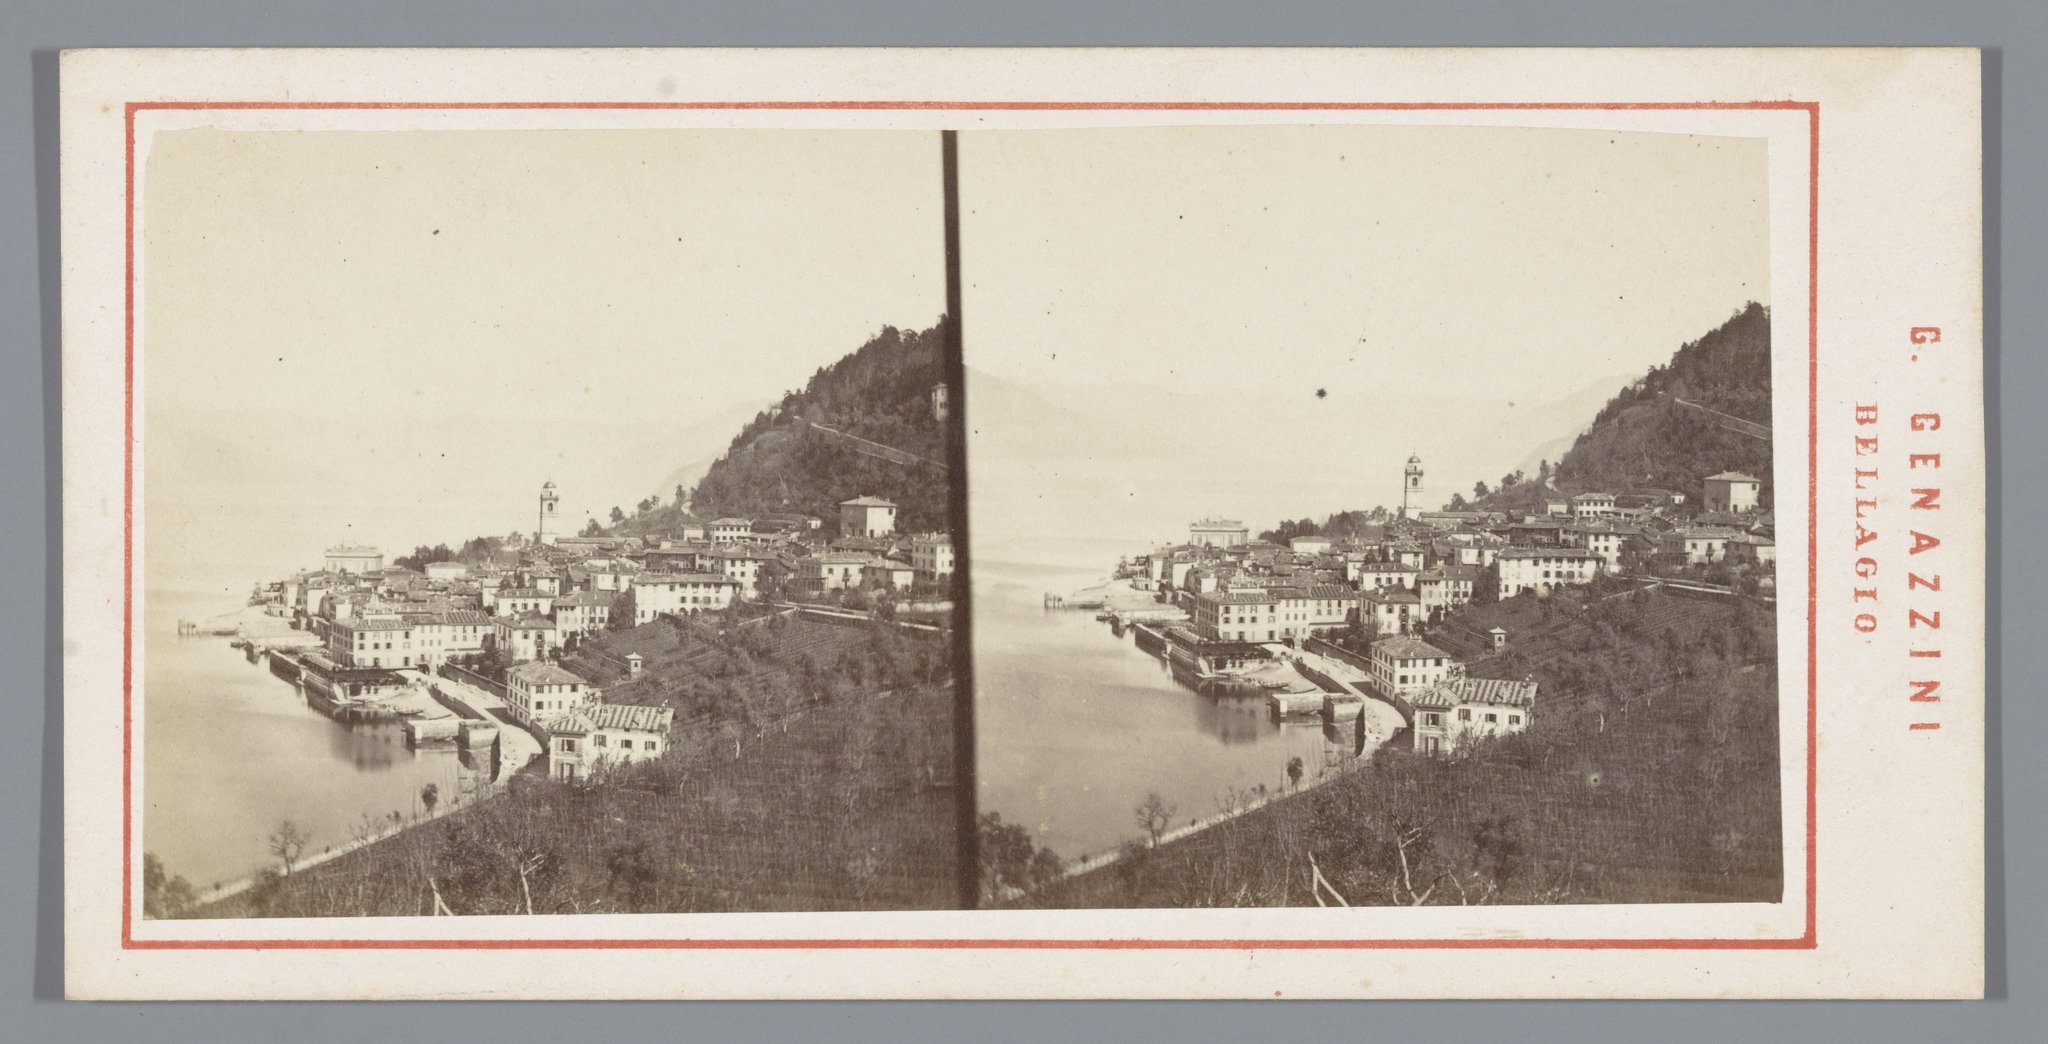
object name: stereograph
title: Gezicht op Bellagio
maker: giorgio genazzini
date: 1860-1870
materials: cardboard, paper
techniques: albumen print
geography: bellagio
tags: prospect of village, silhouette of village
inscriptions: name: ‘G. Genazzini/ Bellagio’